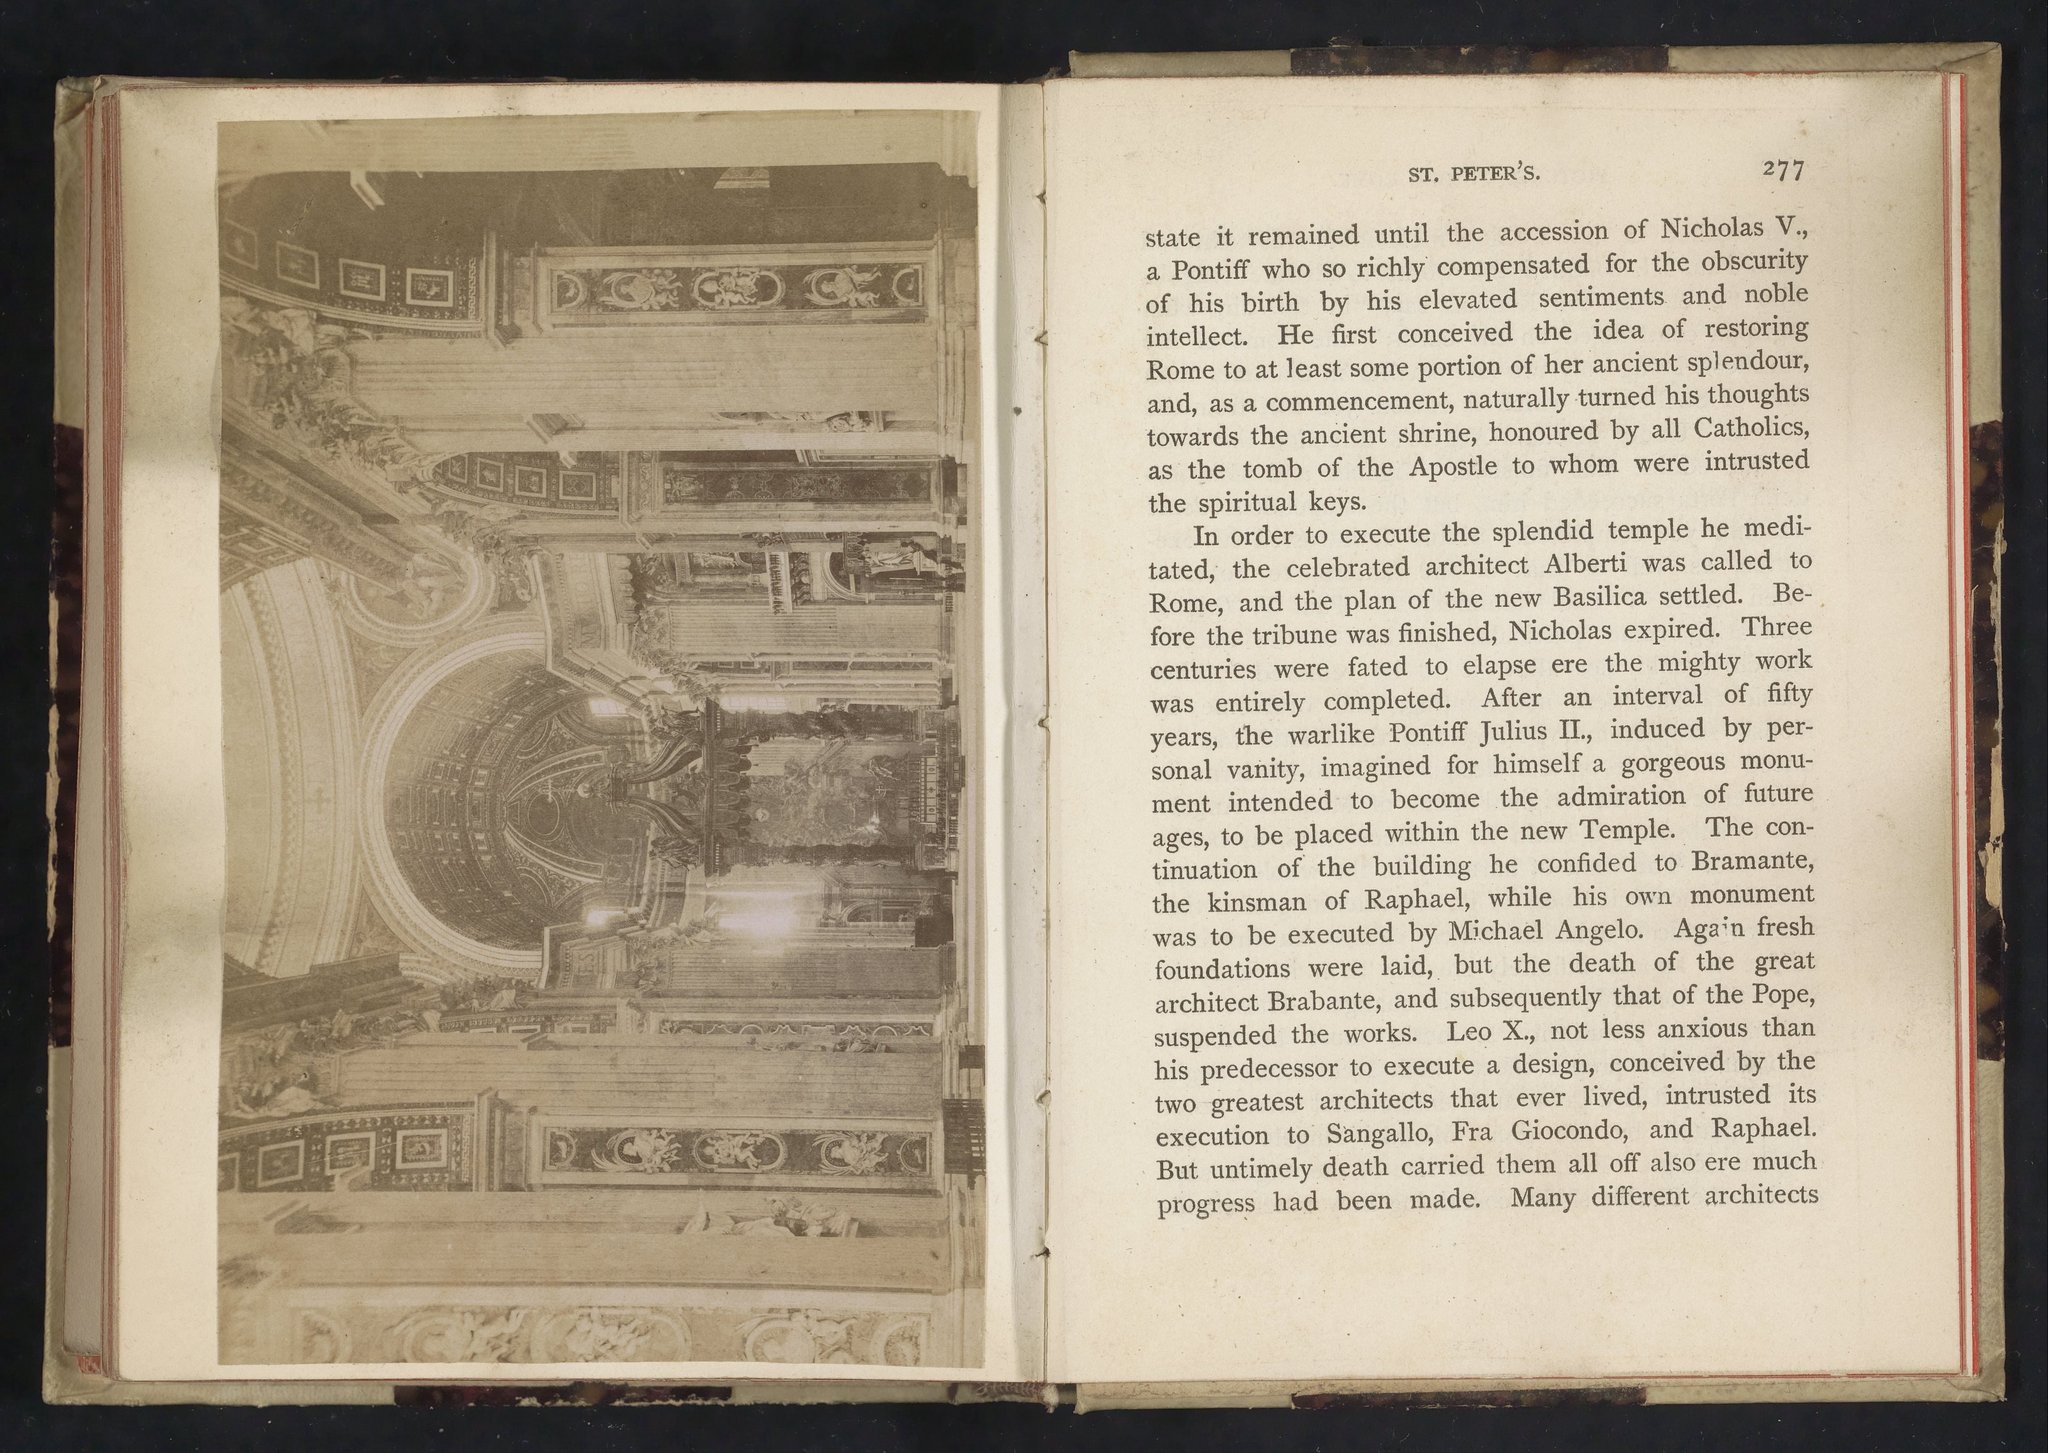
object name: photograph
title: Interieur van de Sint-Pietersbasiliek te Vaticaanstad, met zicht op het Baldakijn van Bernini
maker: Anonymous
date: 1872-1882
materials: photographic support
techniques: albumen print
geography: sint-pietersbasiliek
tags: canopy, baldachin, interior of church